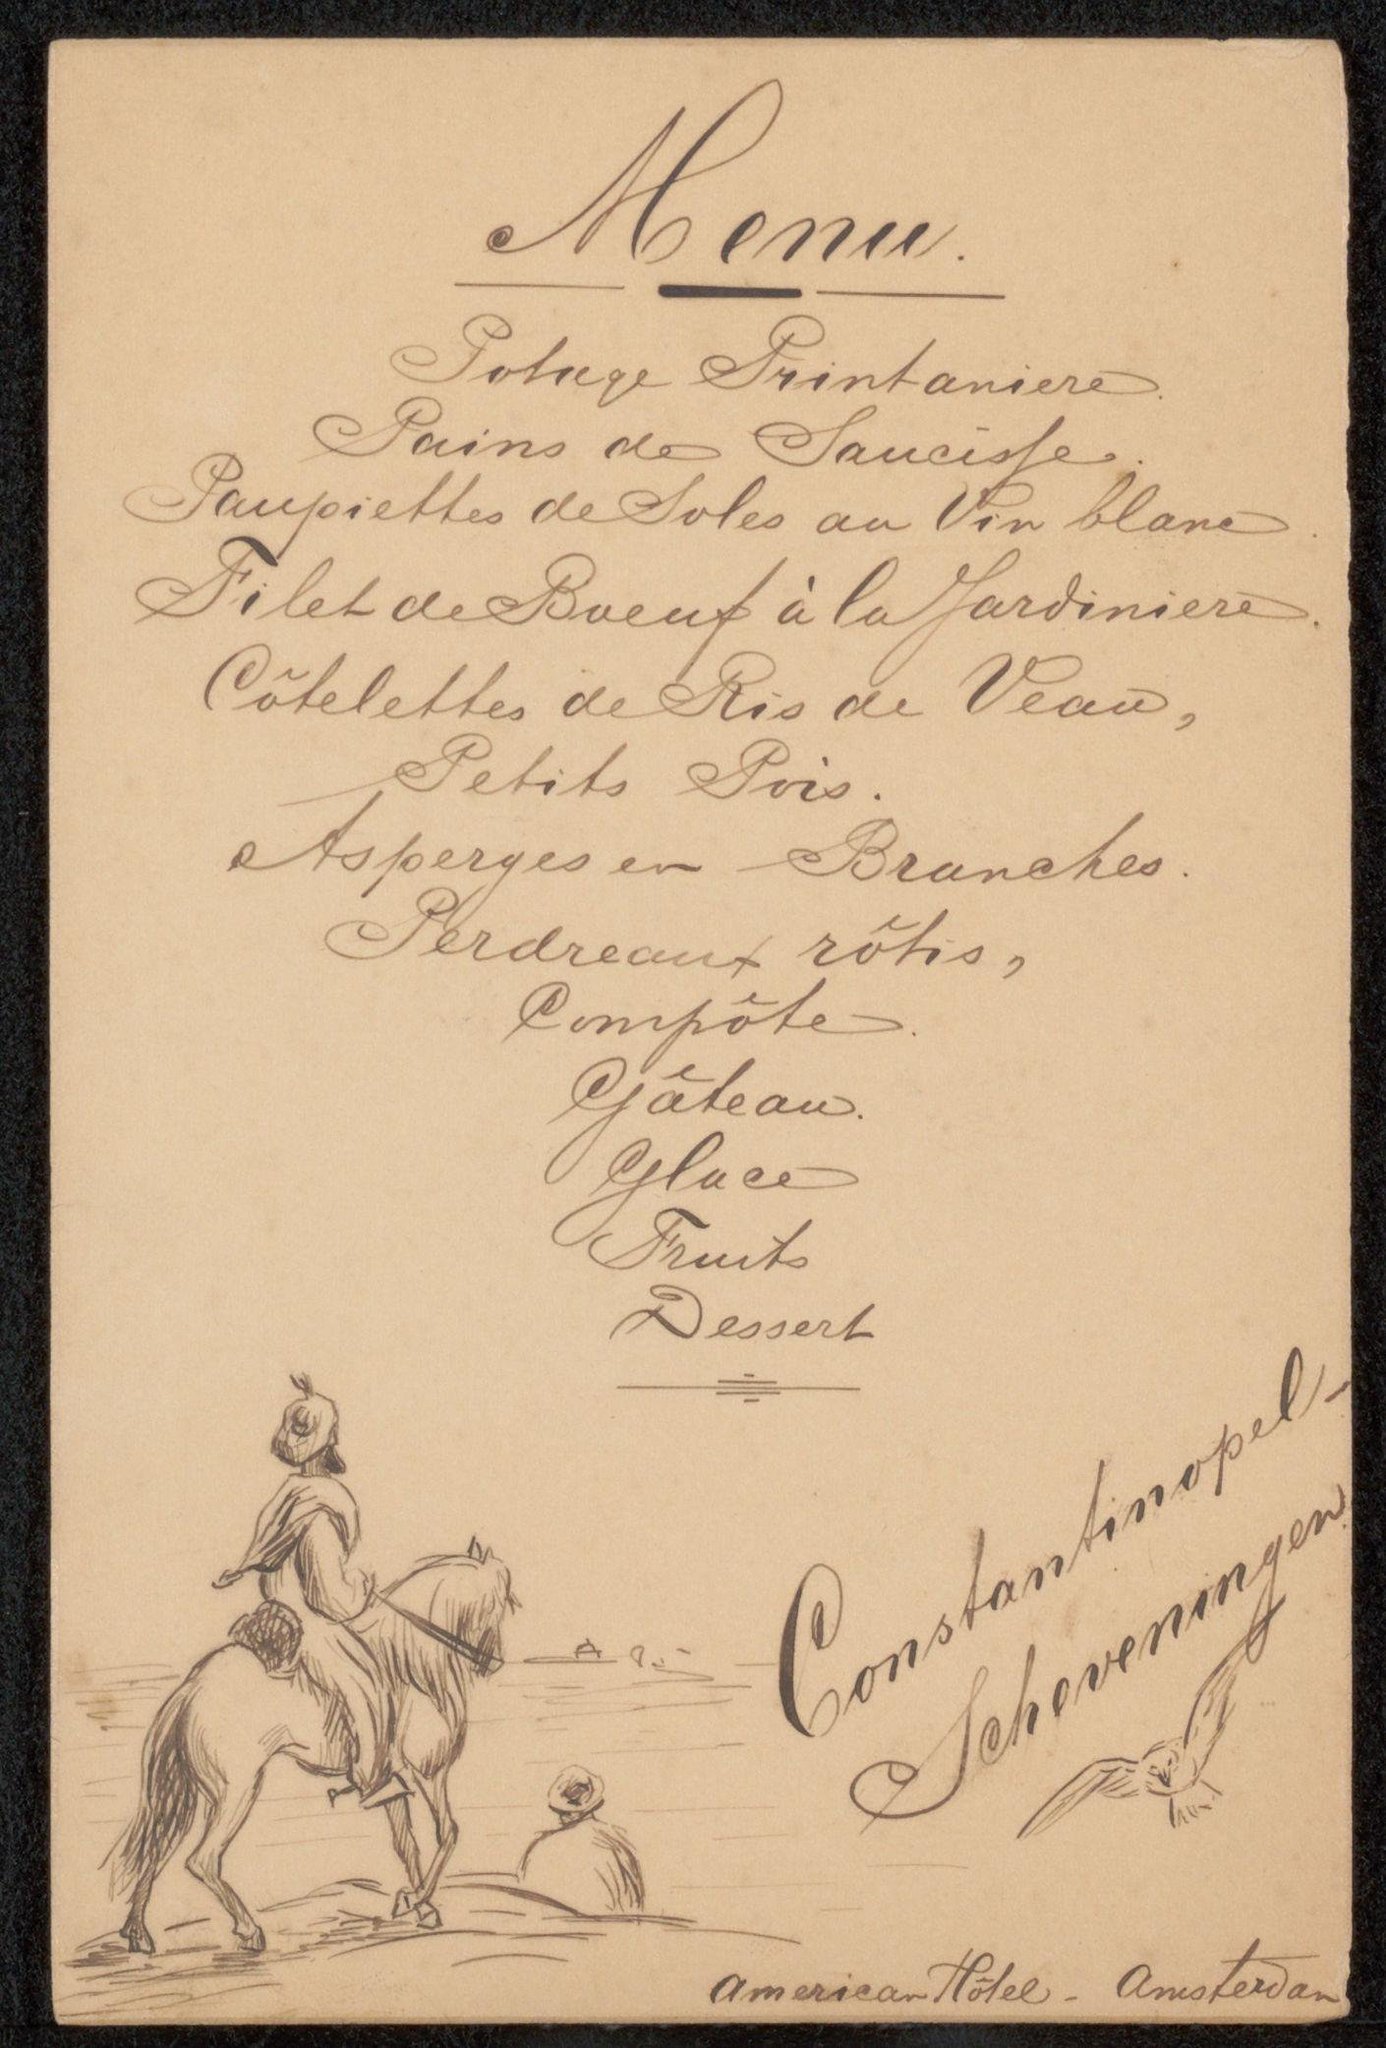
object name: menu, menukaart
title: Menukaart van het ‘Constantinopel-Scheveningen’ diner in het American Hôtel te Amsterdam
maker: marius bauer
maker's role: draughtsman, print maker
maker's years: 1867-1932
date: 1895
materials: cardboard, ink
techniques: pen, writing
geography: amsterdam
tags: amsterdam, print maker, draughtsman, marius bauer, charles snabilié, painter, philip zilcken, riding a horse, ass, or mule; rider, horseman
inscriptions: name: ‘PHZilcken’, name: ‘CSnabilié’, collector's mark: ‘RPK’, name: ‘MBauer’